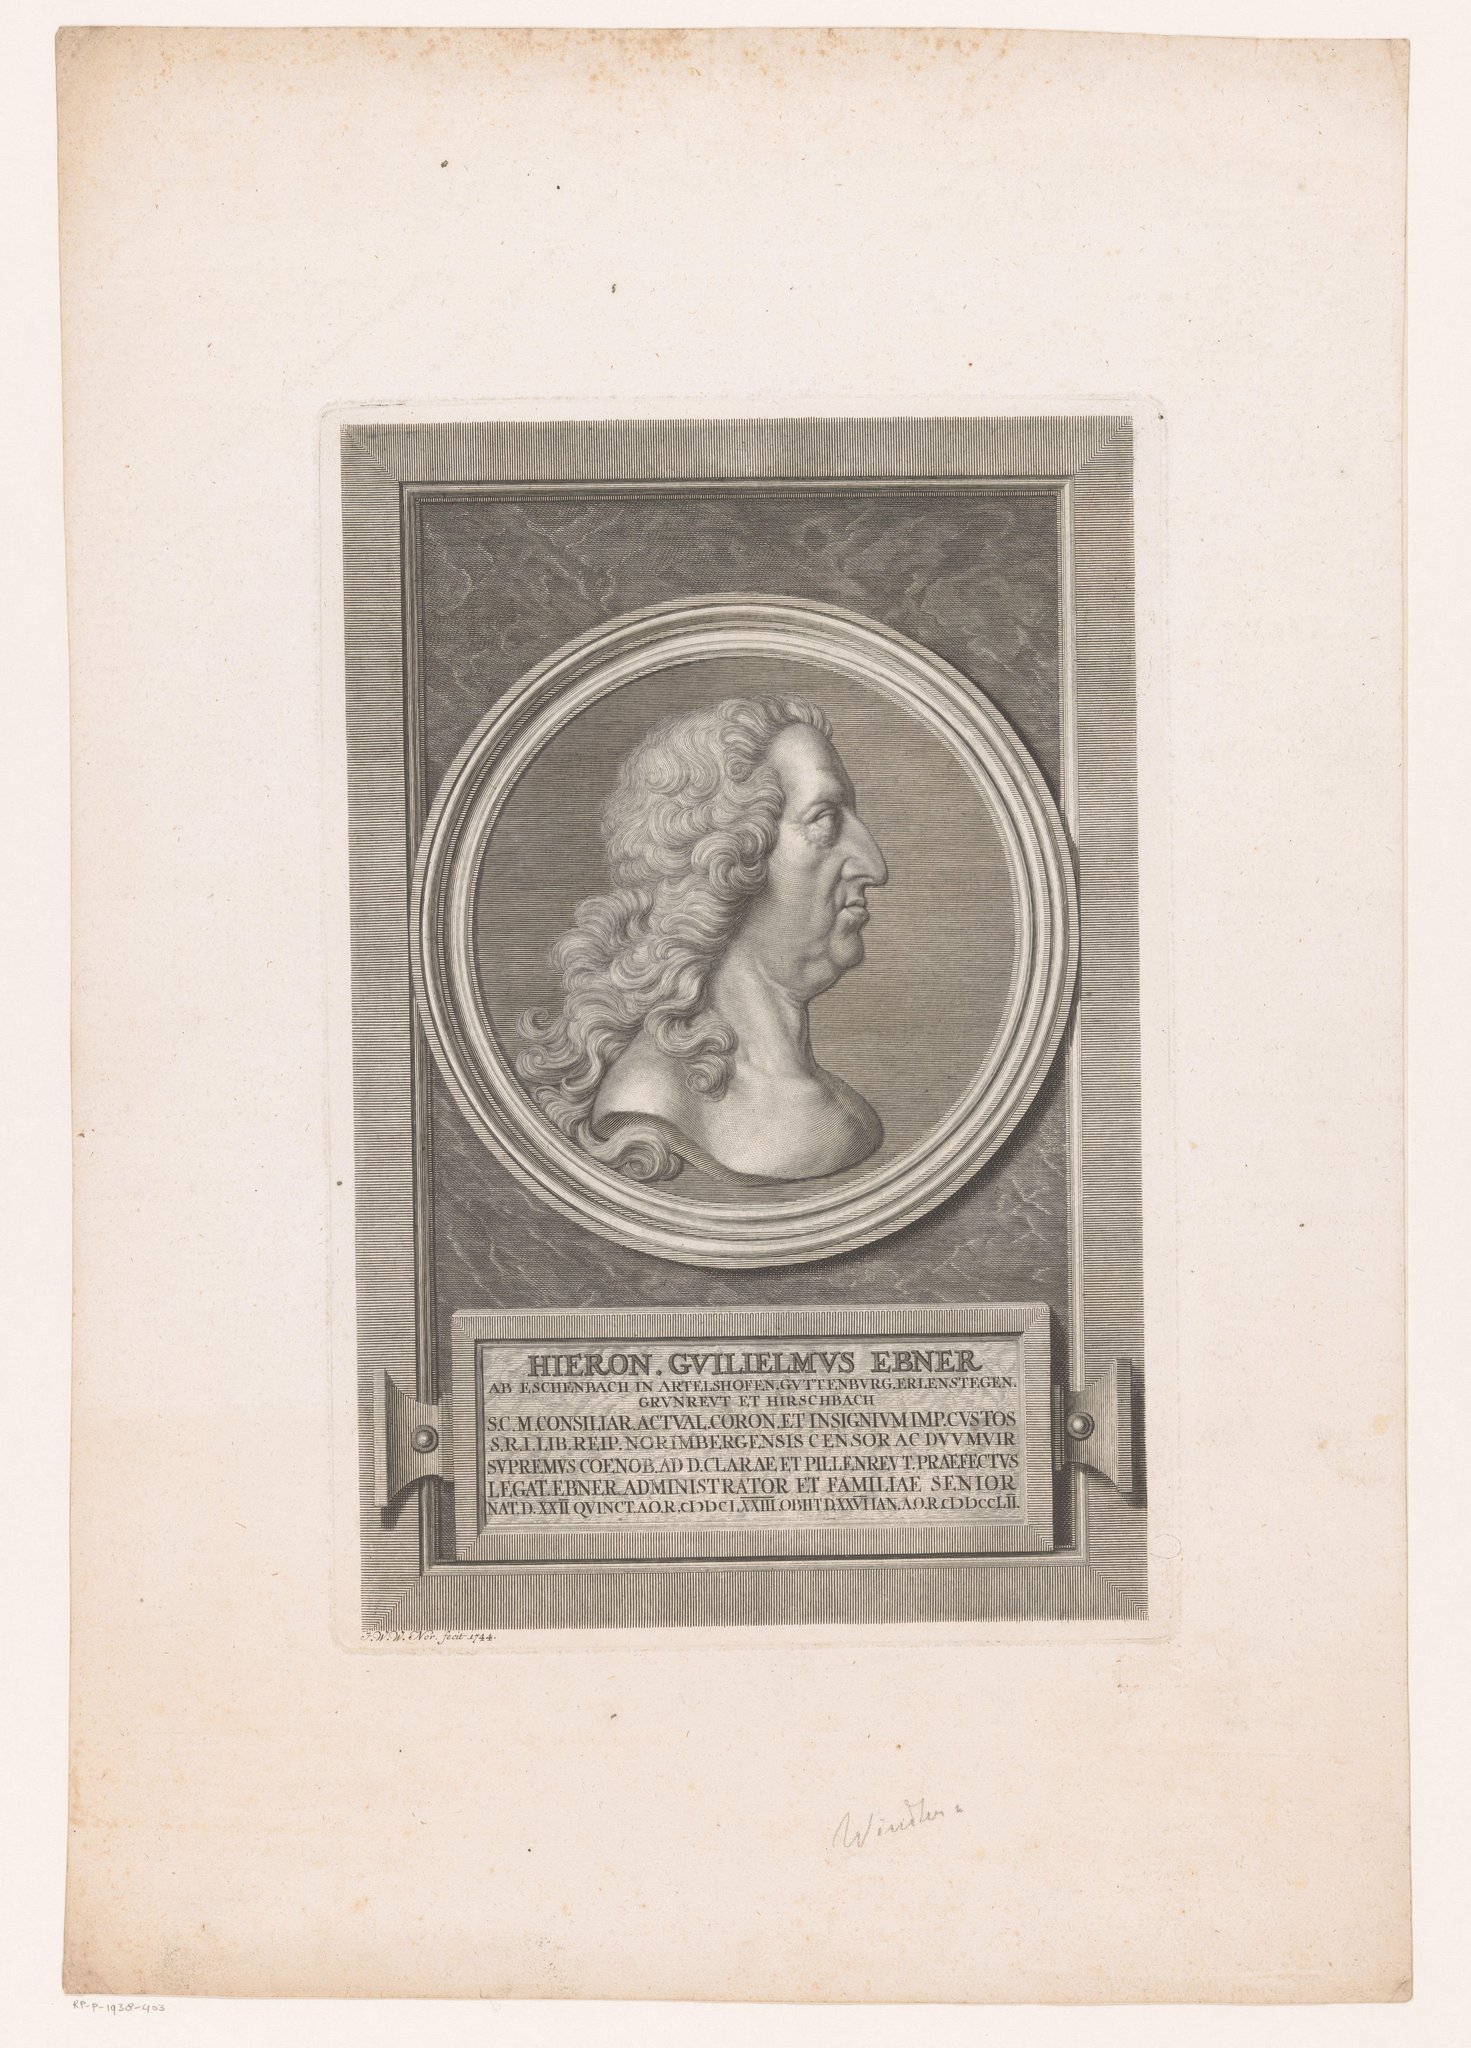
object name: print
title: Portret van Hieronymus Wilhelm Ebner von Eschenbach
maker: johann wilhelm windter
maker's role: draughtsman, print maker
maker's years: 1696-1765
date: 1744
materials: paper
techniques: engraving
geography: nuremberg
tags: historical persons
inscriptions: collector's mark: Lugt 2228